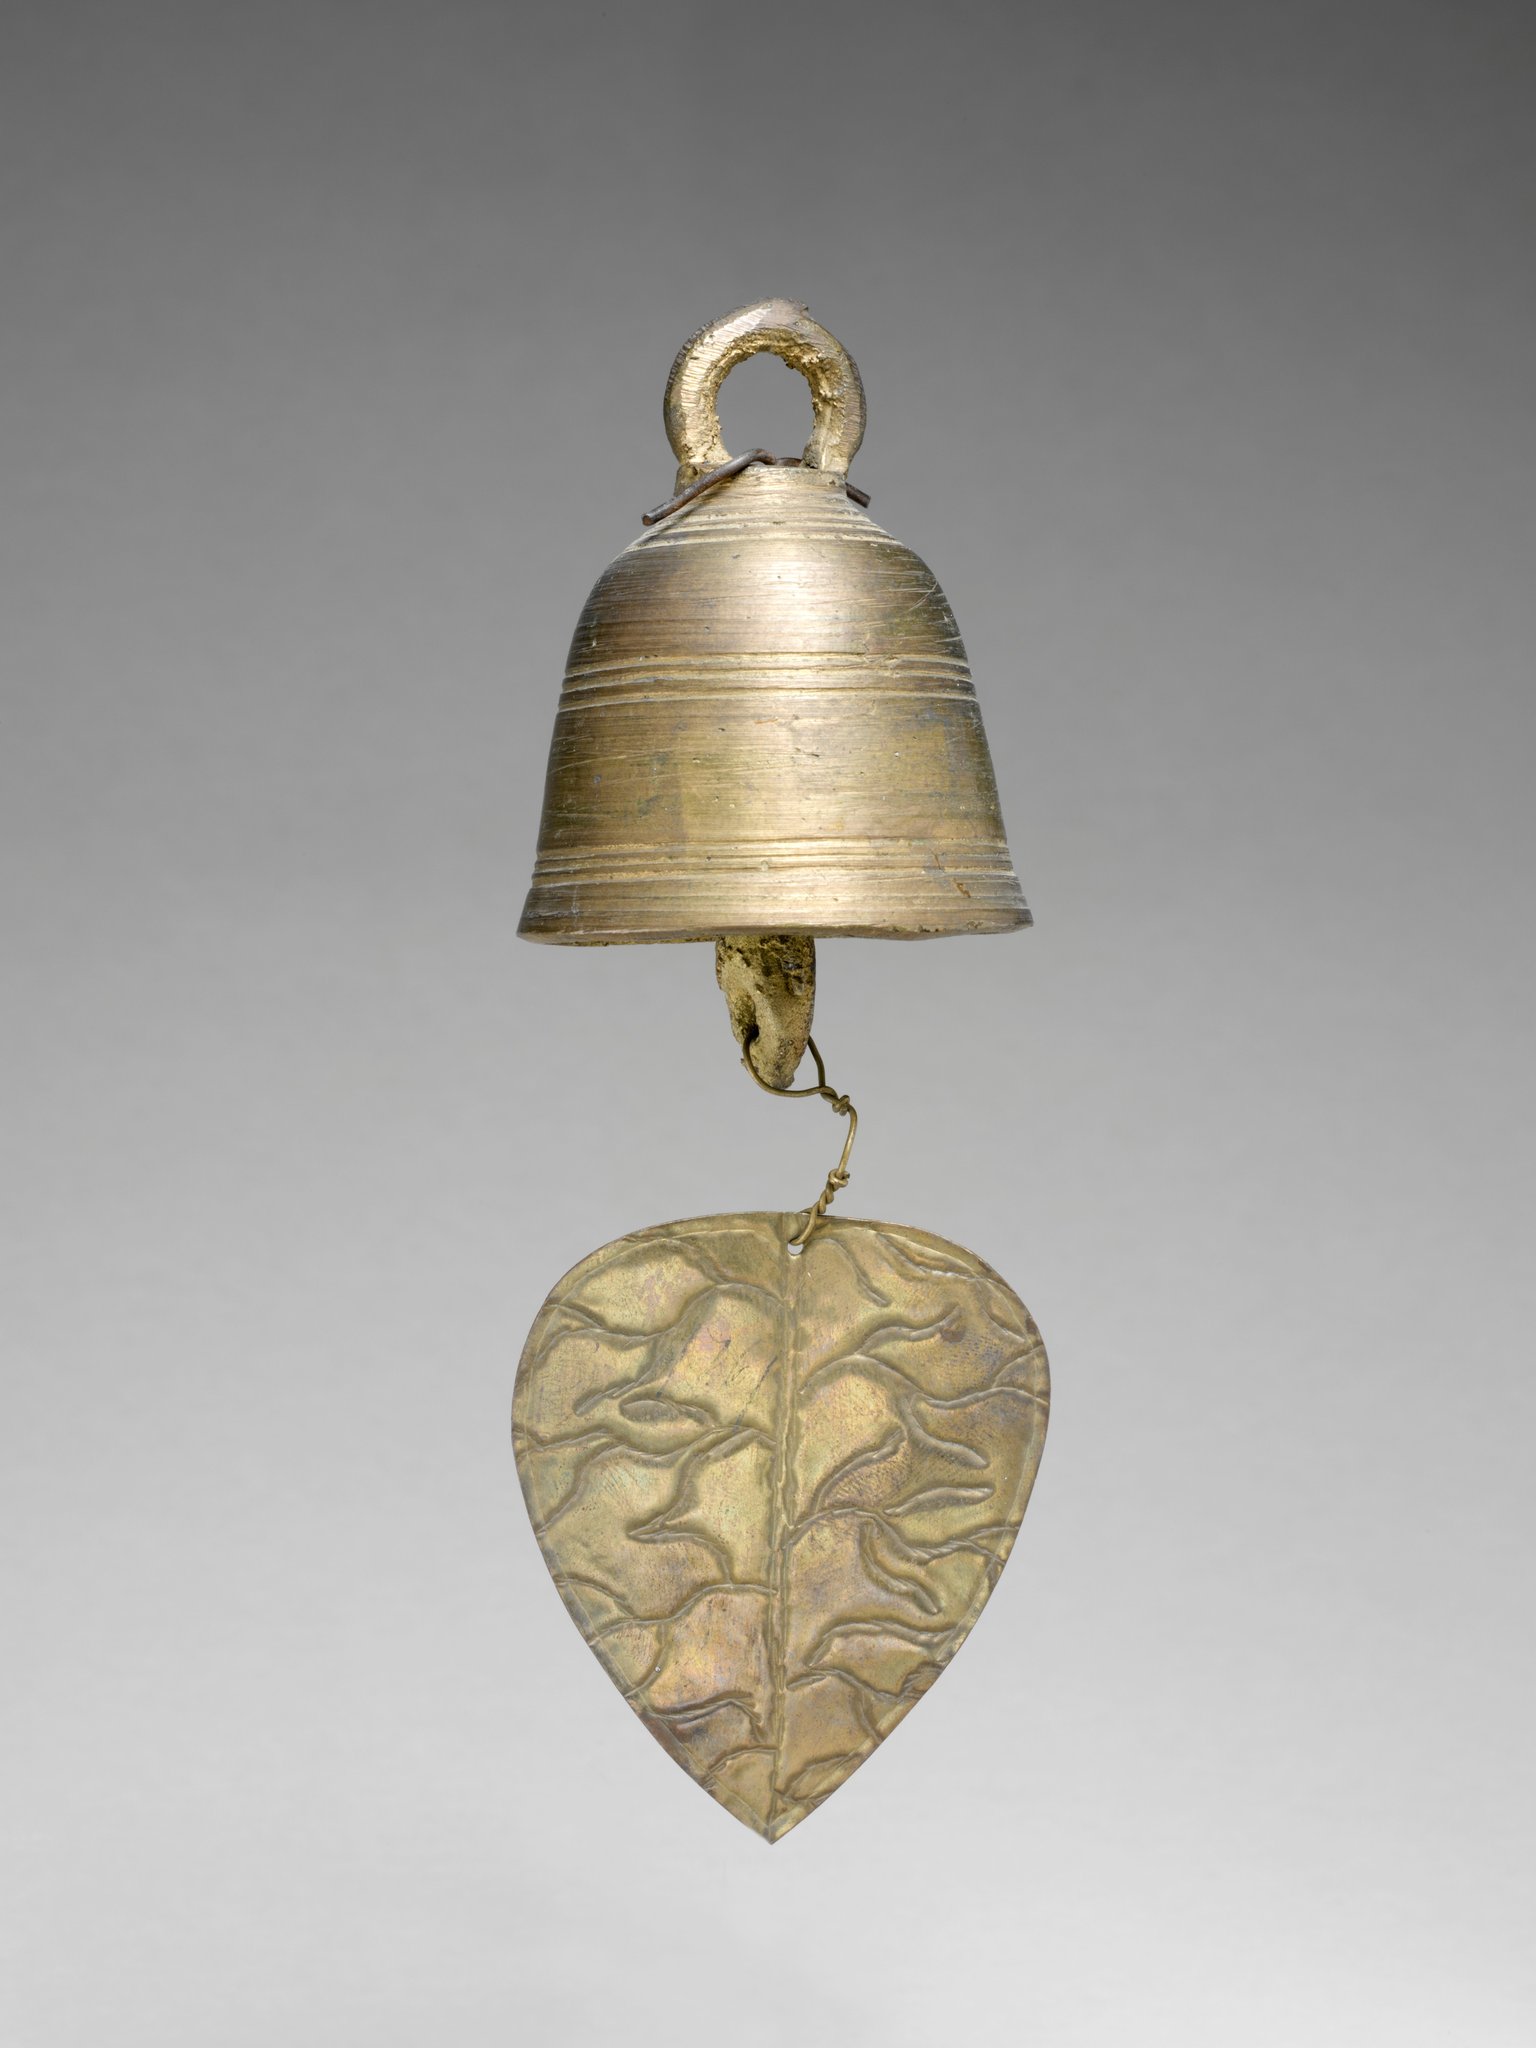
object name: khew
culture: burmese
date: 1867-1900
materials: metal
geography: myanmar